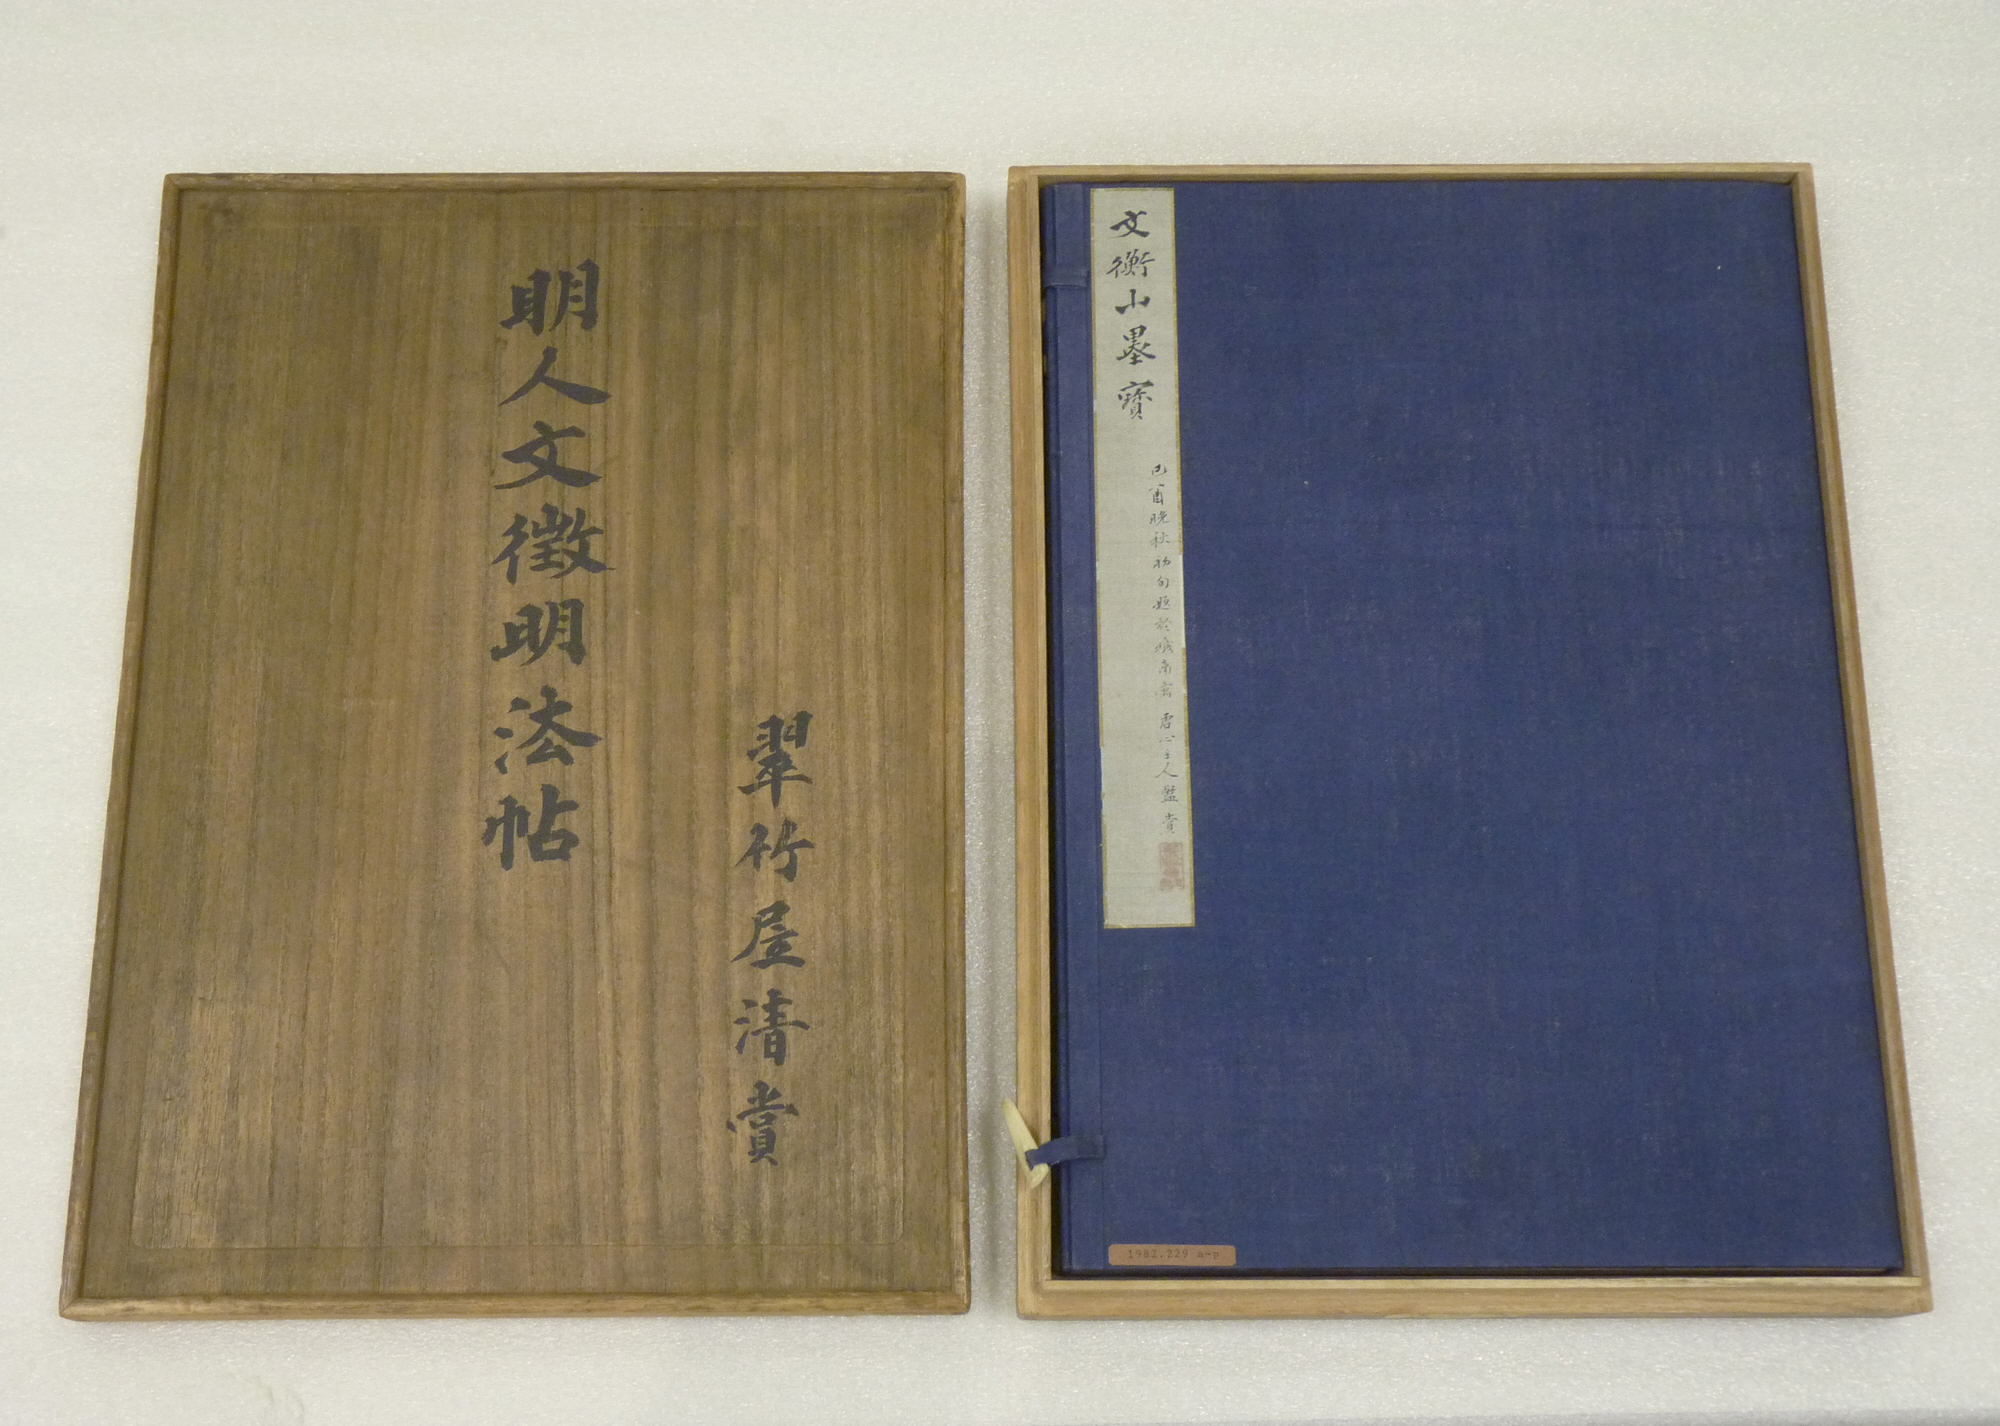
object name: album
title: Poem on Strolling in the Moonlight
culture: chinese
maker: wen zhengming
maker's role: artist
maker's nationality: chinese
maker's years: 1470-1559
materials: ink, paper